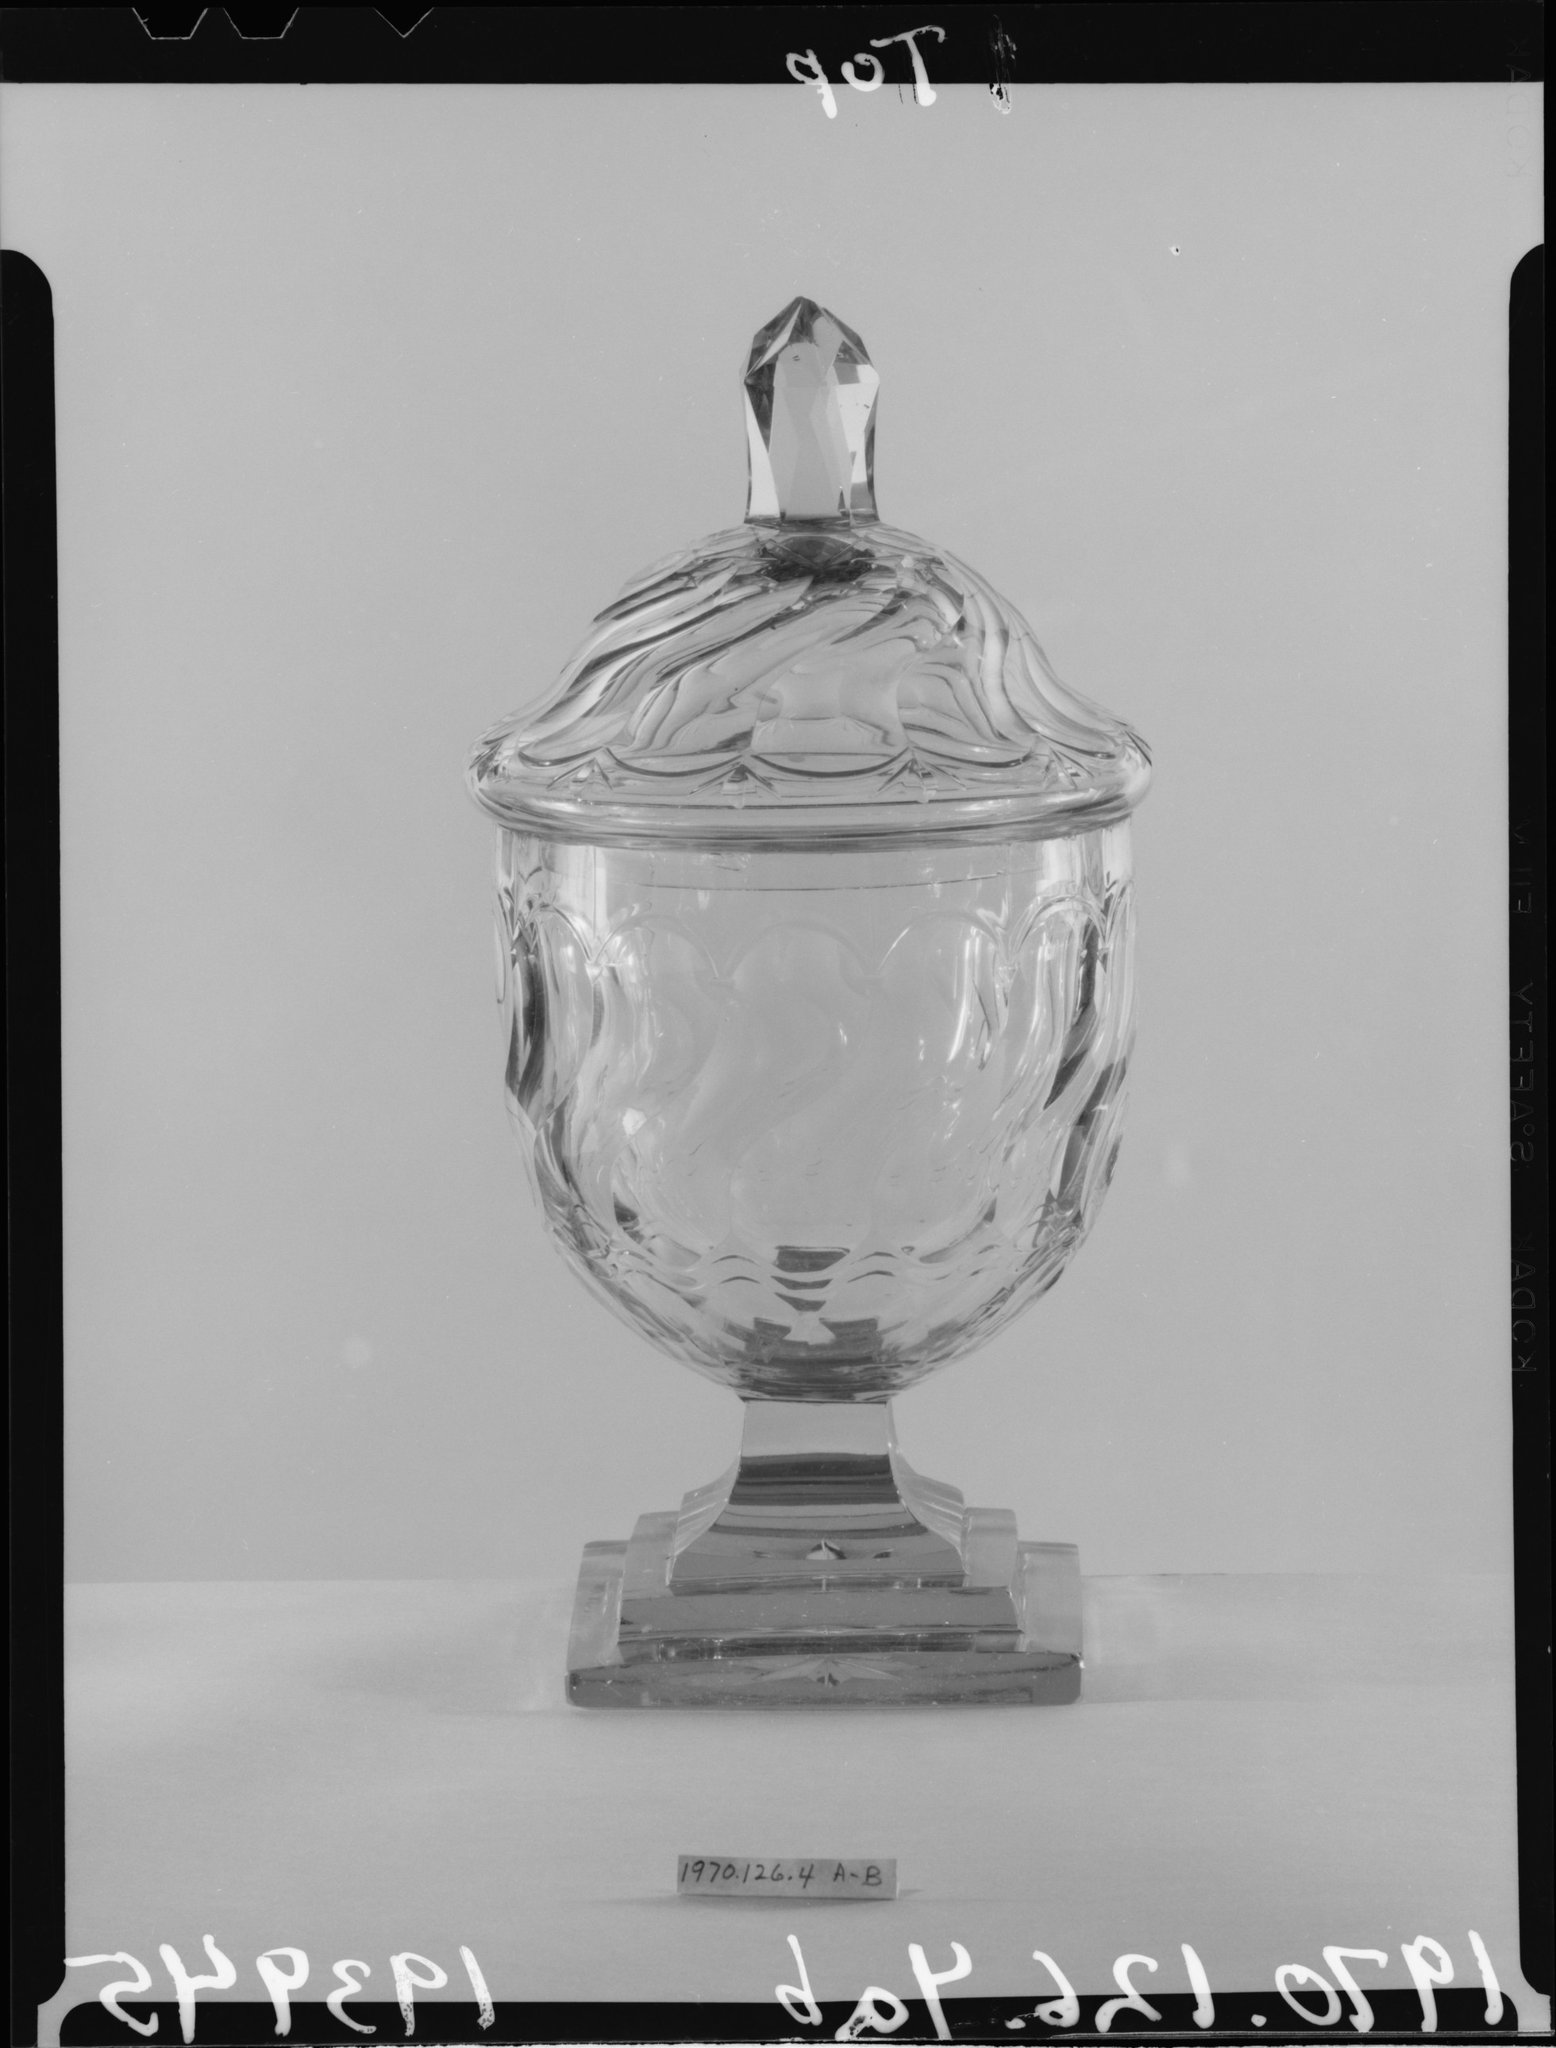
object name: sweetmeat jar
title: Covered Sweetmeat Jar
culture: irish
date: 1775-1800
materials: glass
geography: ireland